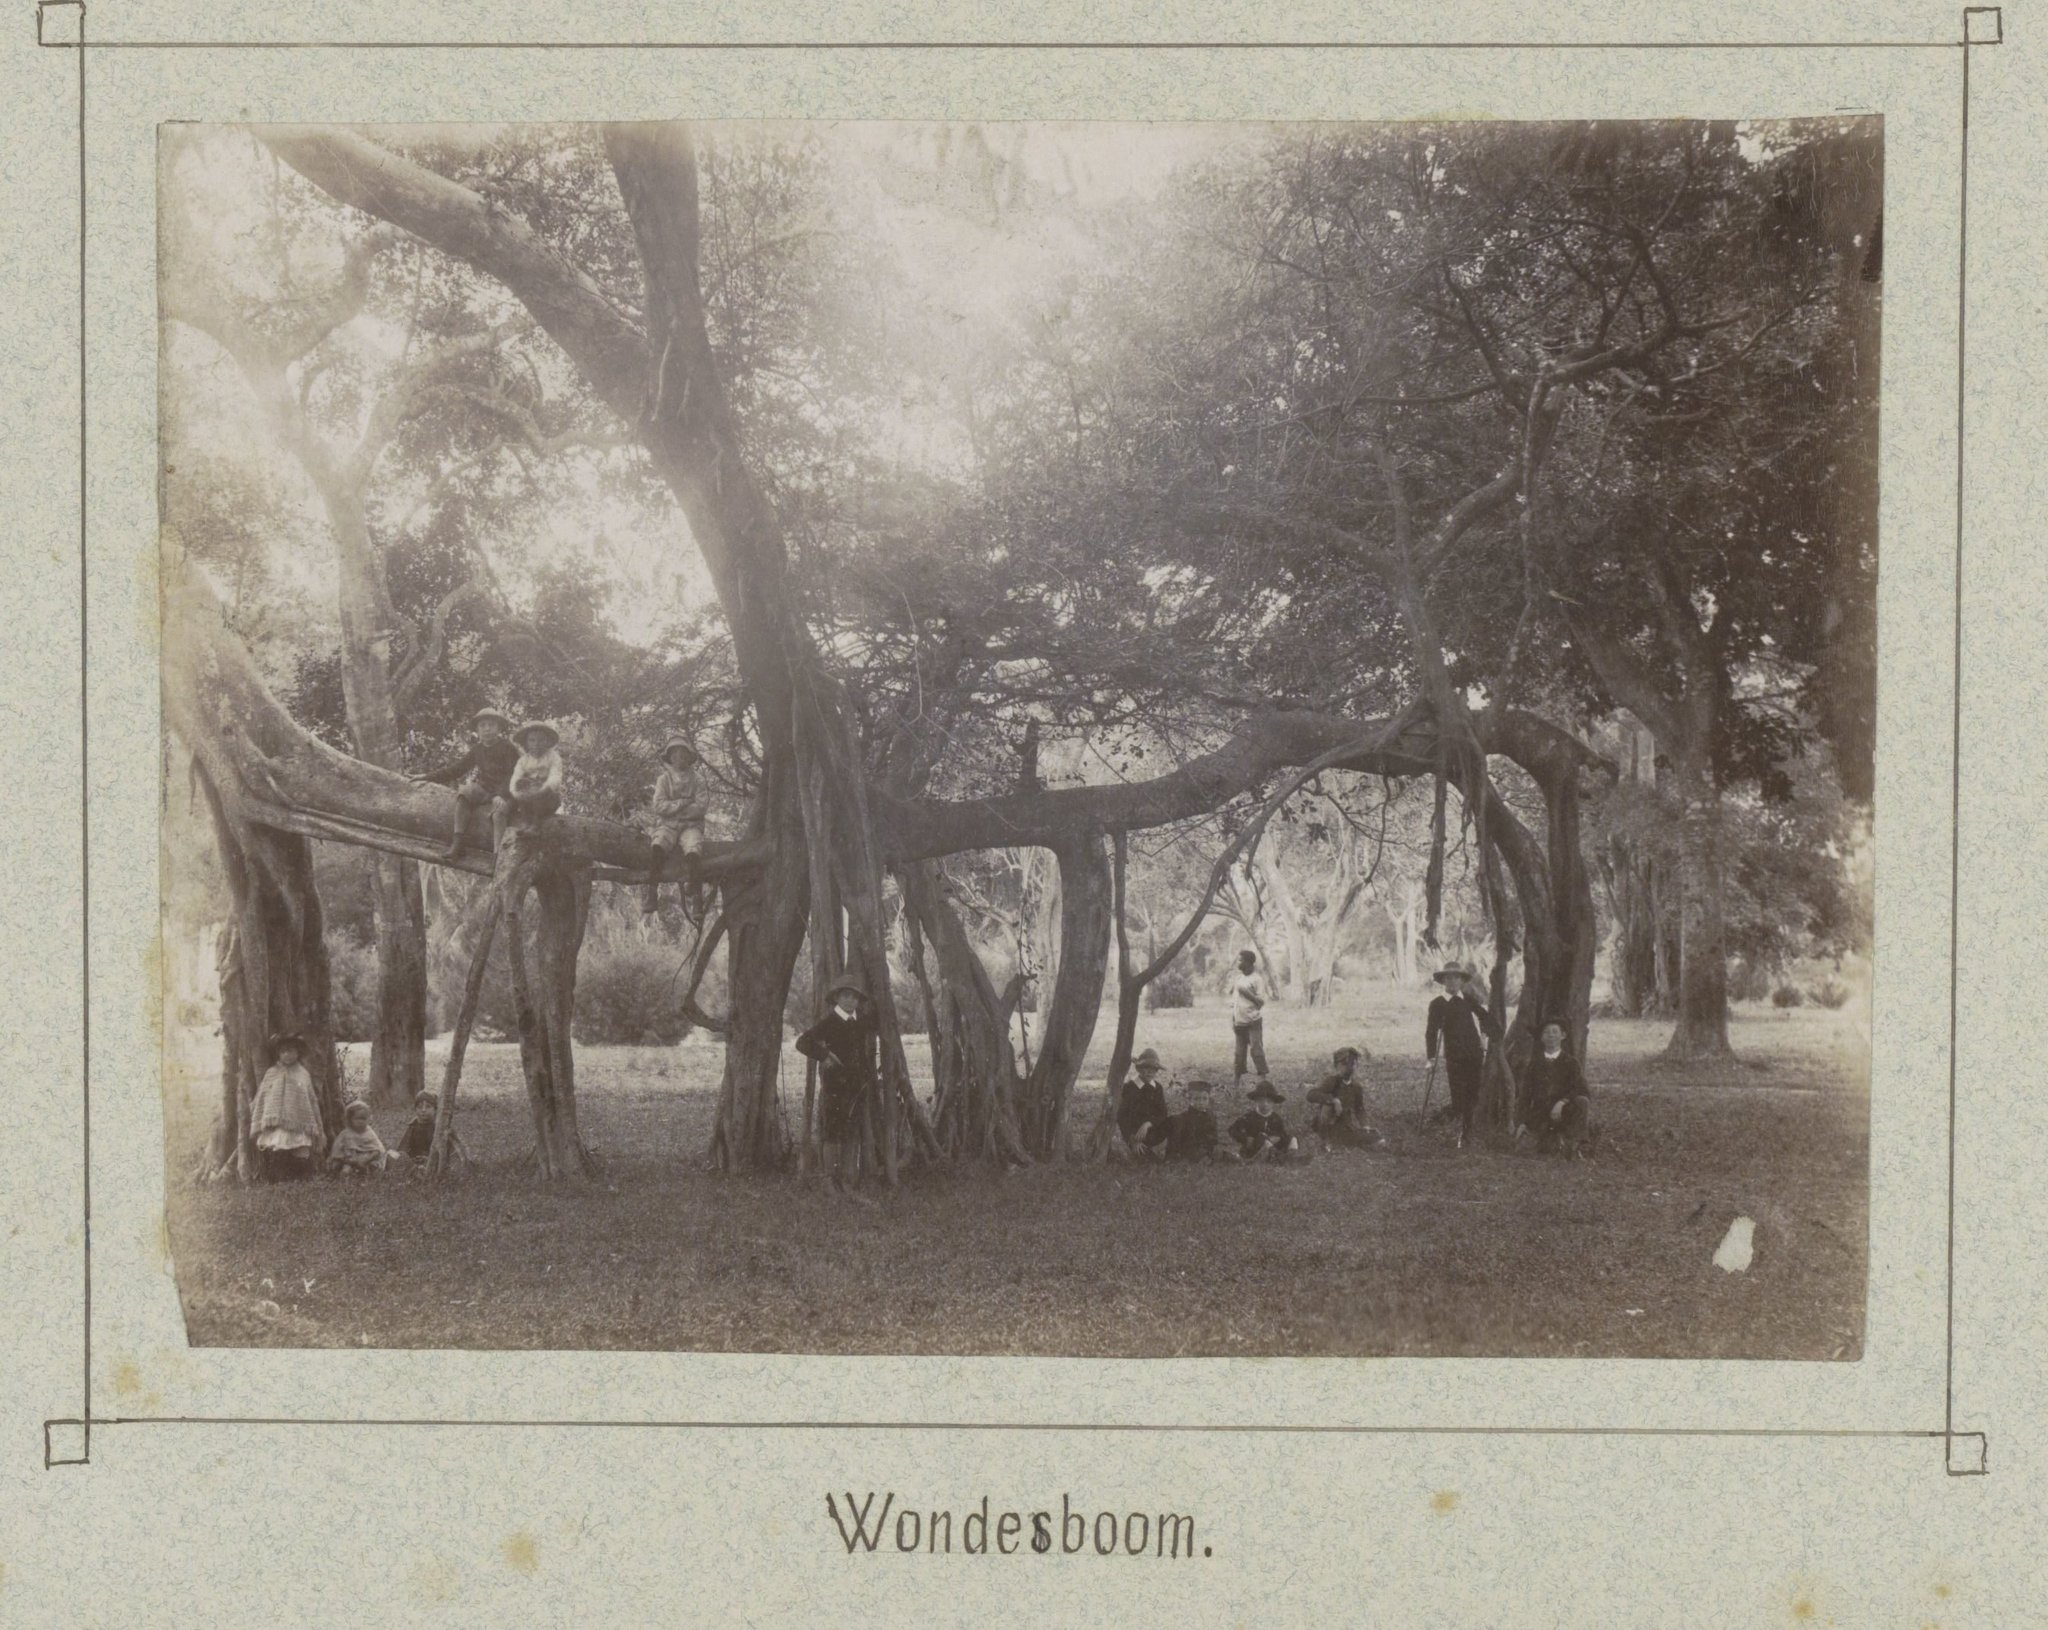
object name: photograph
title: Wonderboom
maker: Anonymous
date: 1880-1900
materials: photographic support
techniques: albumen print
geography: south africa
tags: trees, child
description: Onderdeel van Reisalbum met foto's van Zuid-Afrika, Madeira, Portugal, Frankrijk en Duitsland.